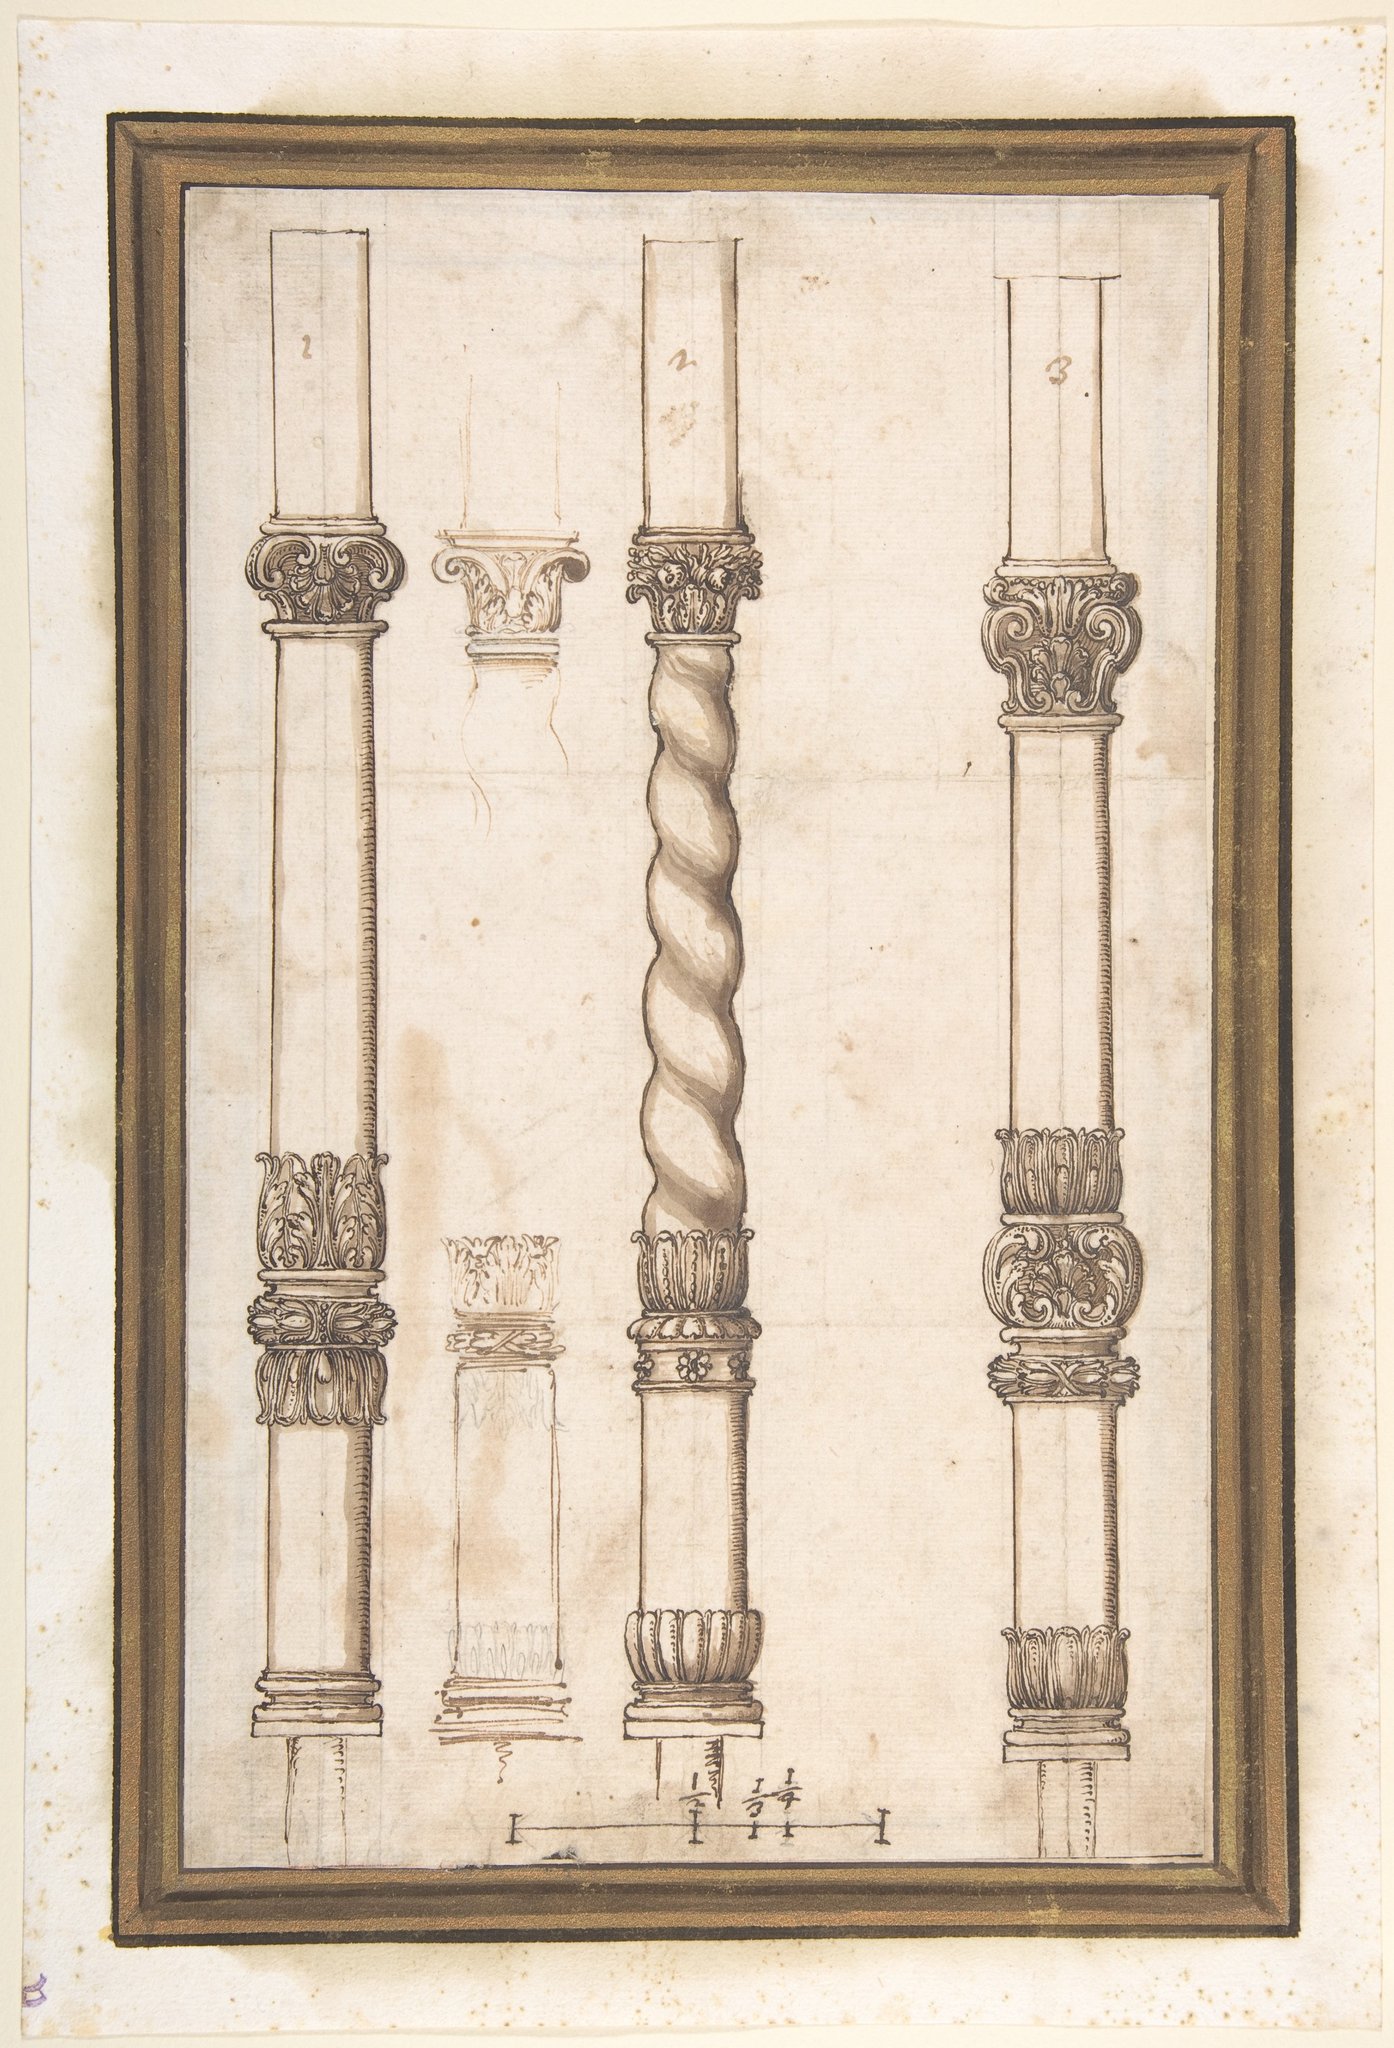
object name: drawing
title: Four Designs for Pillars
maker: anonymous, italian, 18th century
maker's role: artist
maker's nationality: italian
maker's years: 1700-1800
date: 1701-1800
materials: ink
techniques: pen, wash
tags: columns